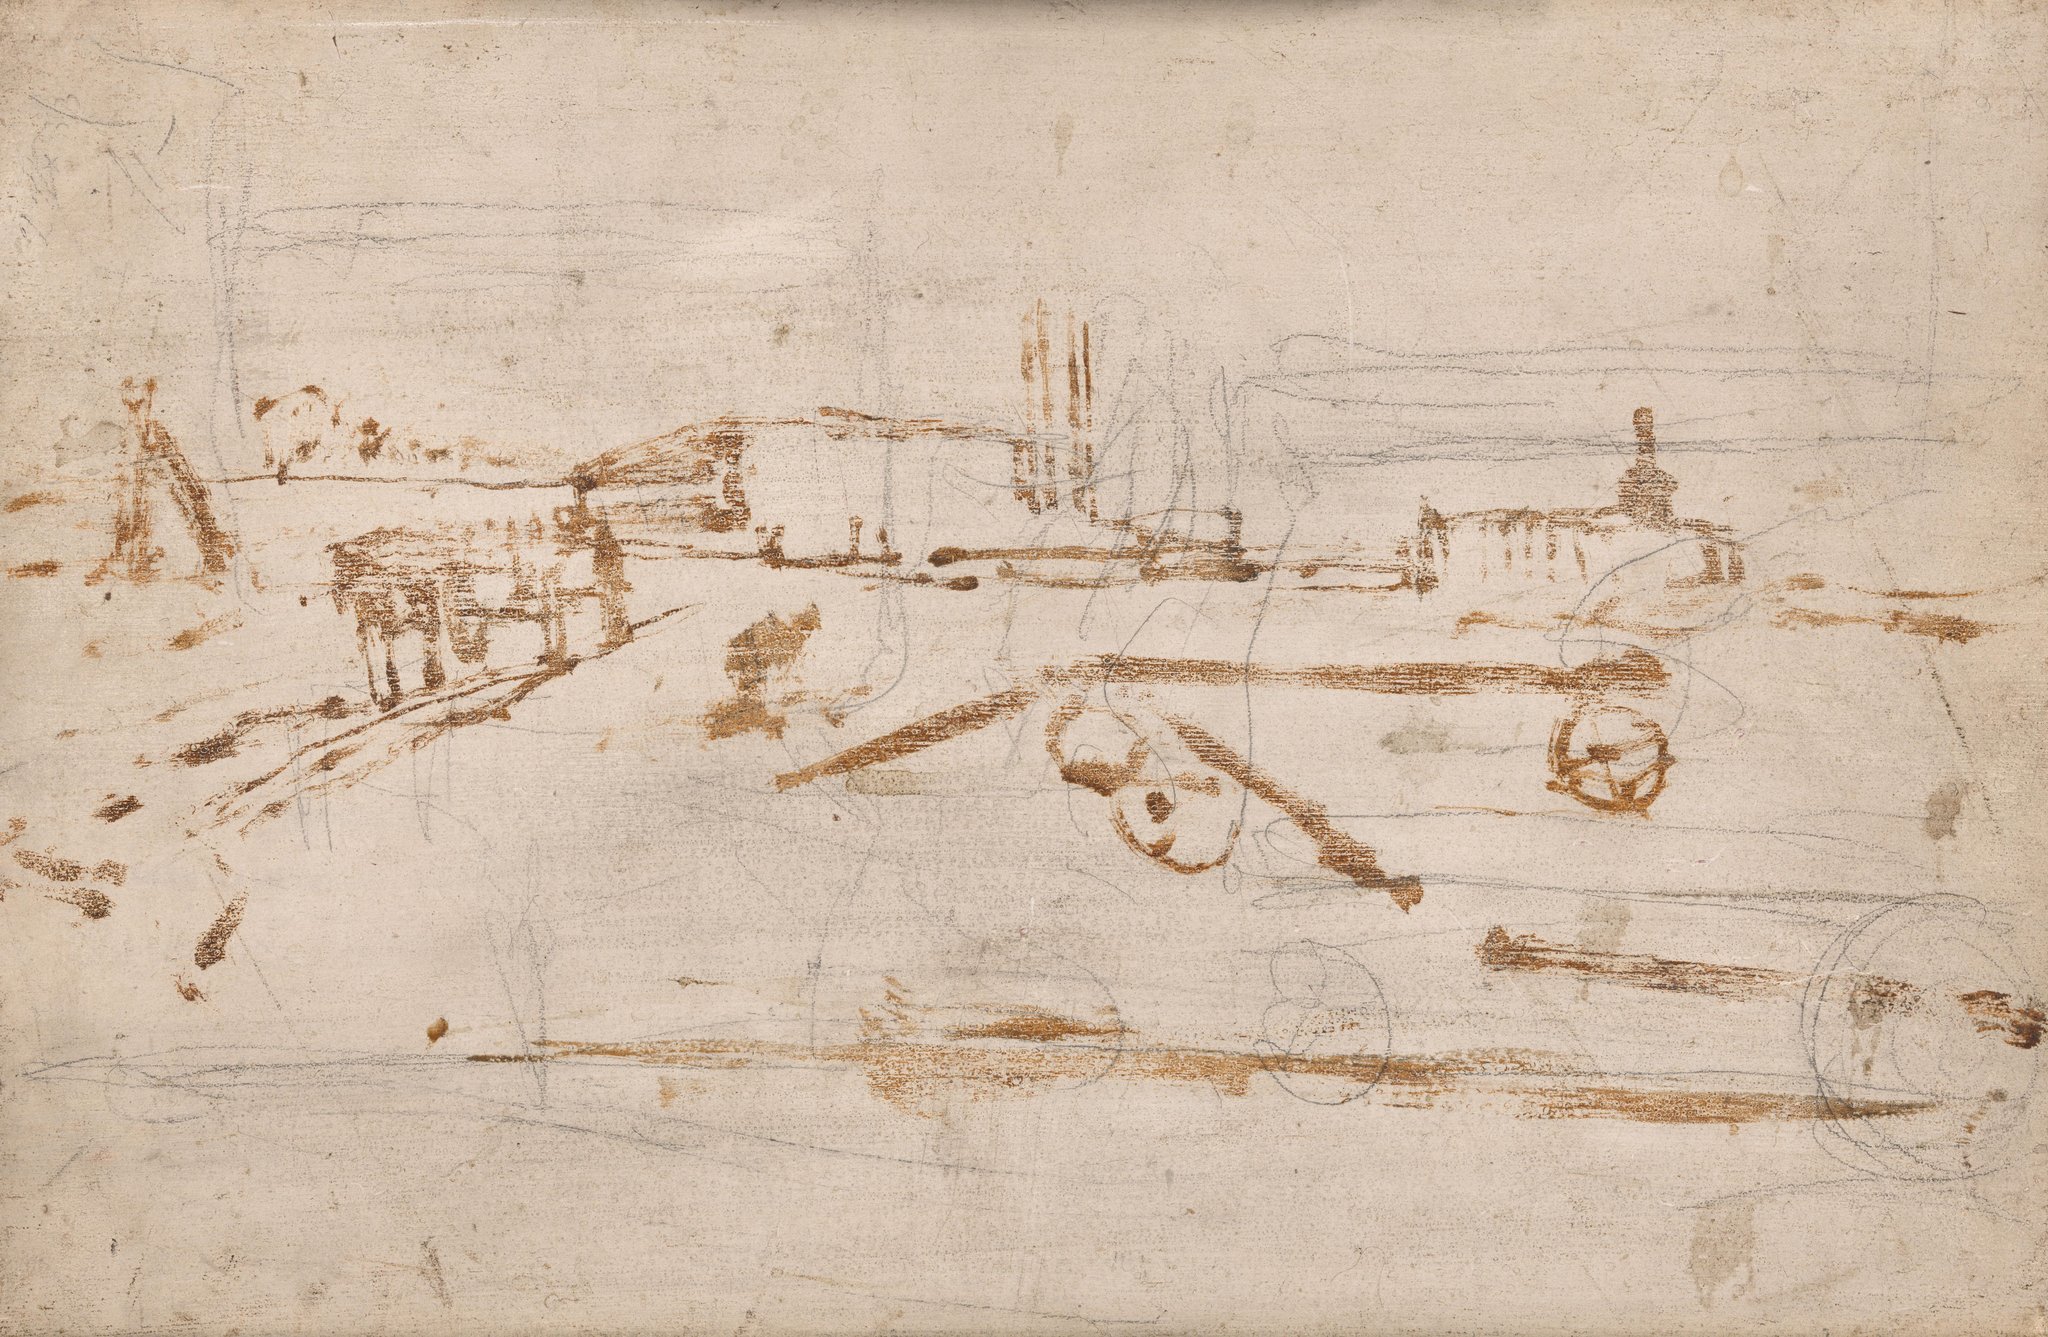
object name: painting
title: The Edge of a City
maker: george hendrik breitner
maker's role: draughtsman, painter, print maker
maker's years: 1857-1923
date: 1880-1923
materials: oil, panel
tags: city-view in general; 'veduta'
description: De buitenrand van een stad. Vage schets met een staande kar en een kar getrokken door een paard. In de verte gebouwen.